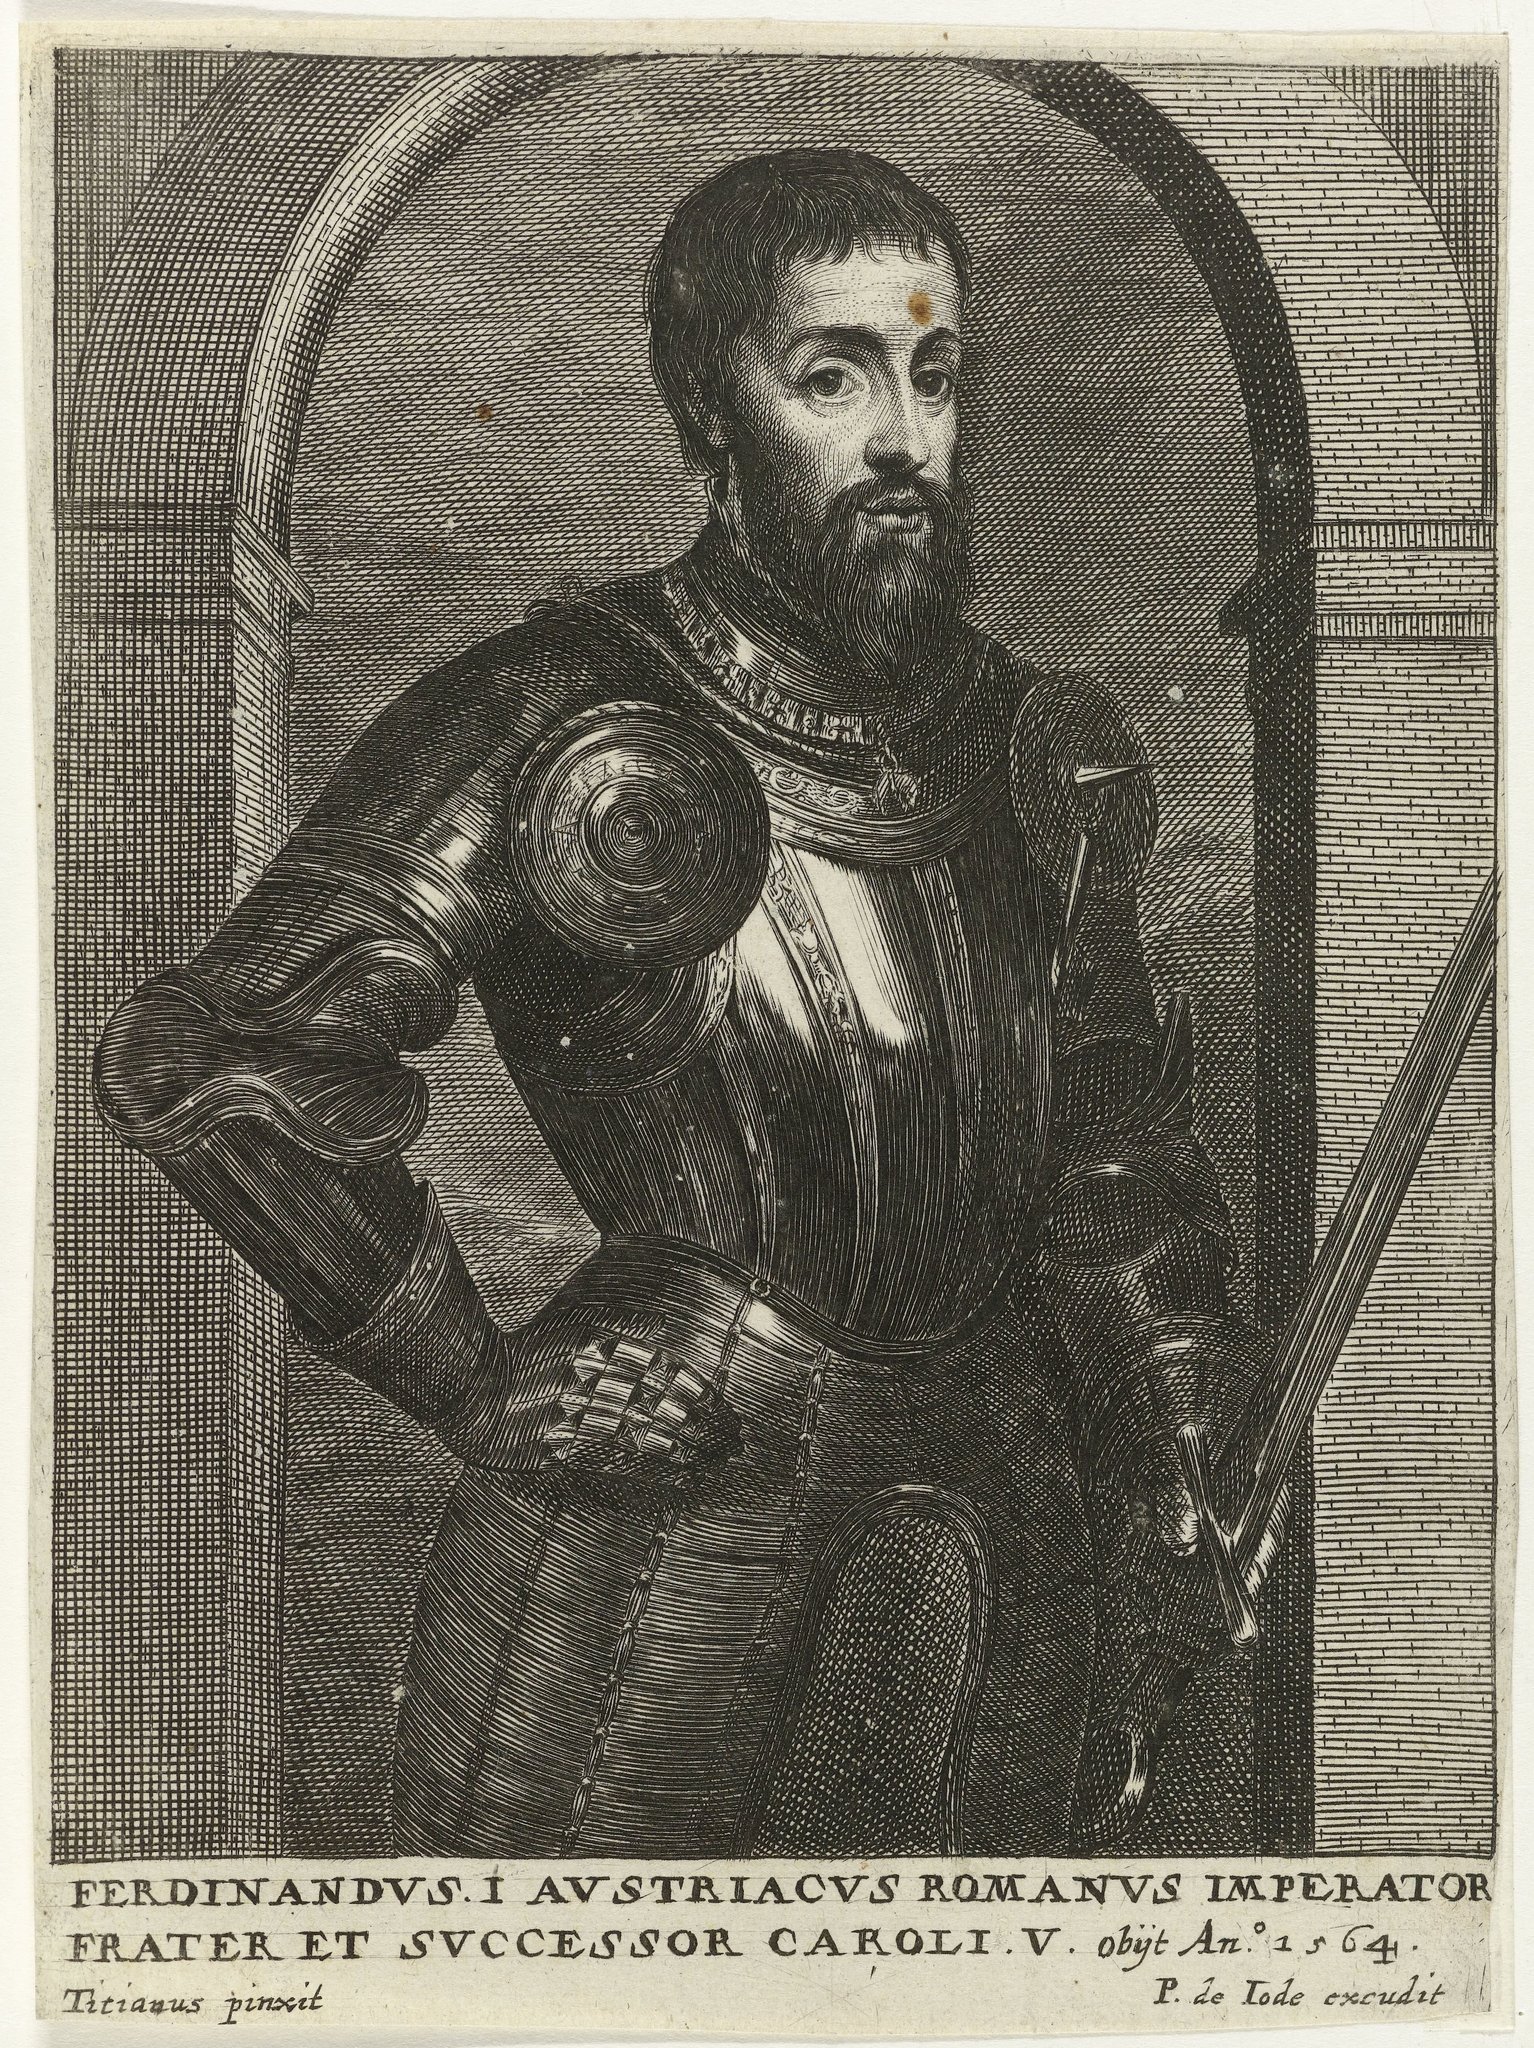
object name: print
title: Theater van bisschoppen, keizers, koningen, hertogen, prinsen, enz.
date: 1651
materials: paper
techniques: engraving, etching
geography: antwerp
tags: vienna, ferdinand i van habsburg (duits keizer), armour, historical persons, hacking and thrusting weapons: sword, emperor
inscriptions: collector's mark: Lugt 2228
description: Portret van Ferdinand I van Habsburg, ten halven lijve. Hij draagt een harnas en houdt een zwaard in zijn linkerhand. In de marge een tweeregelig onderschrift in het Latijn.